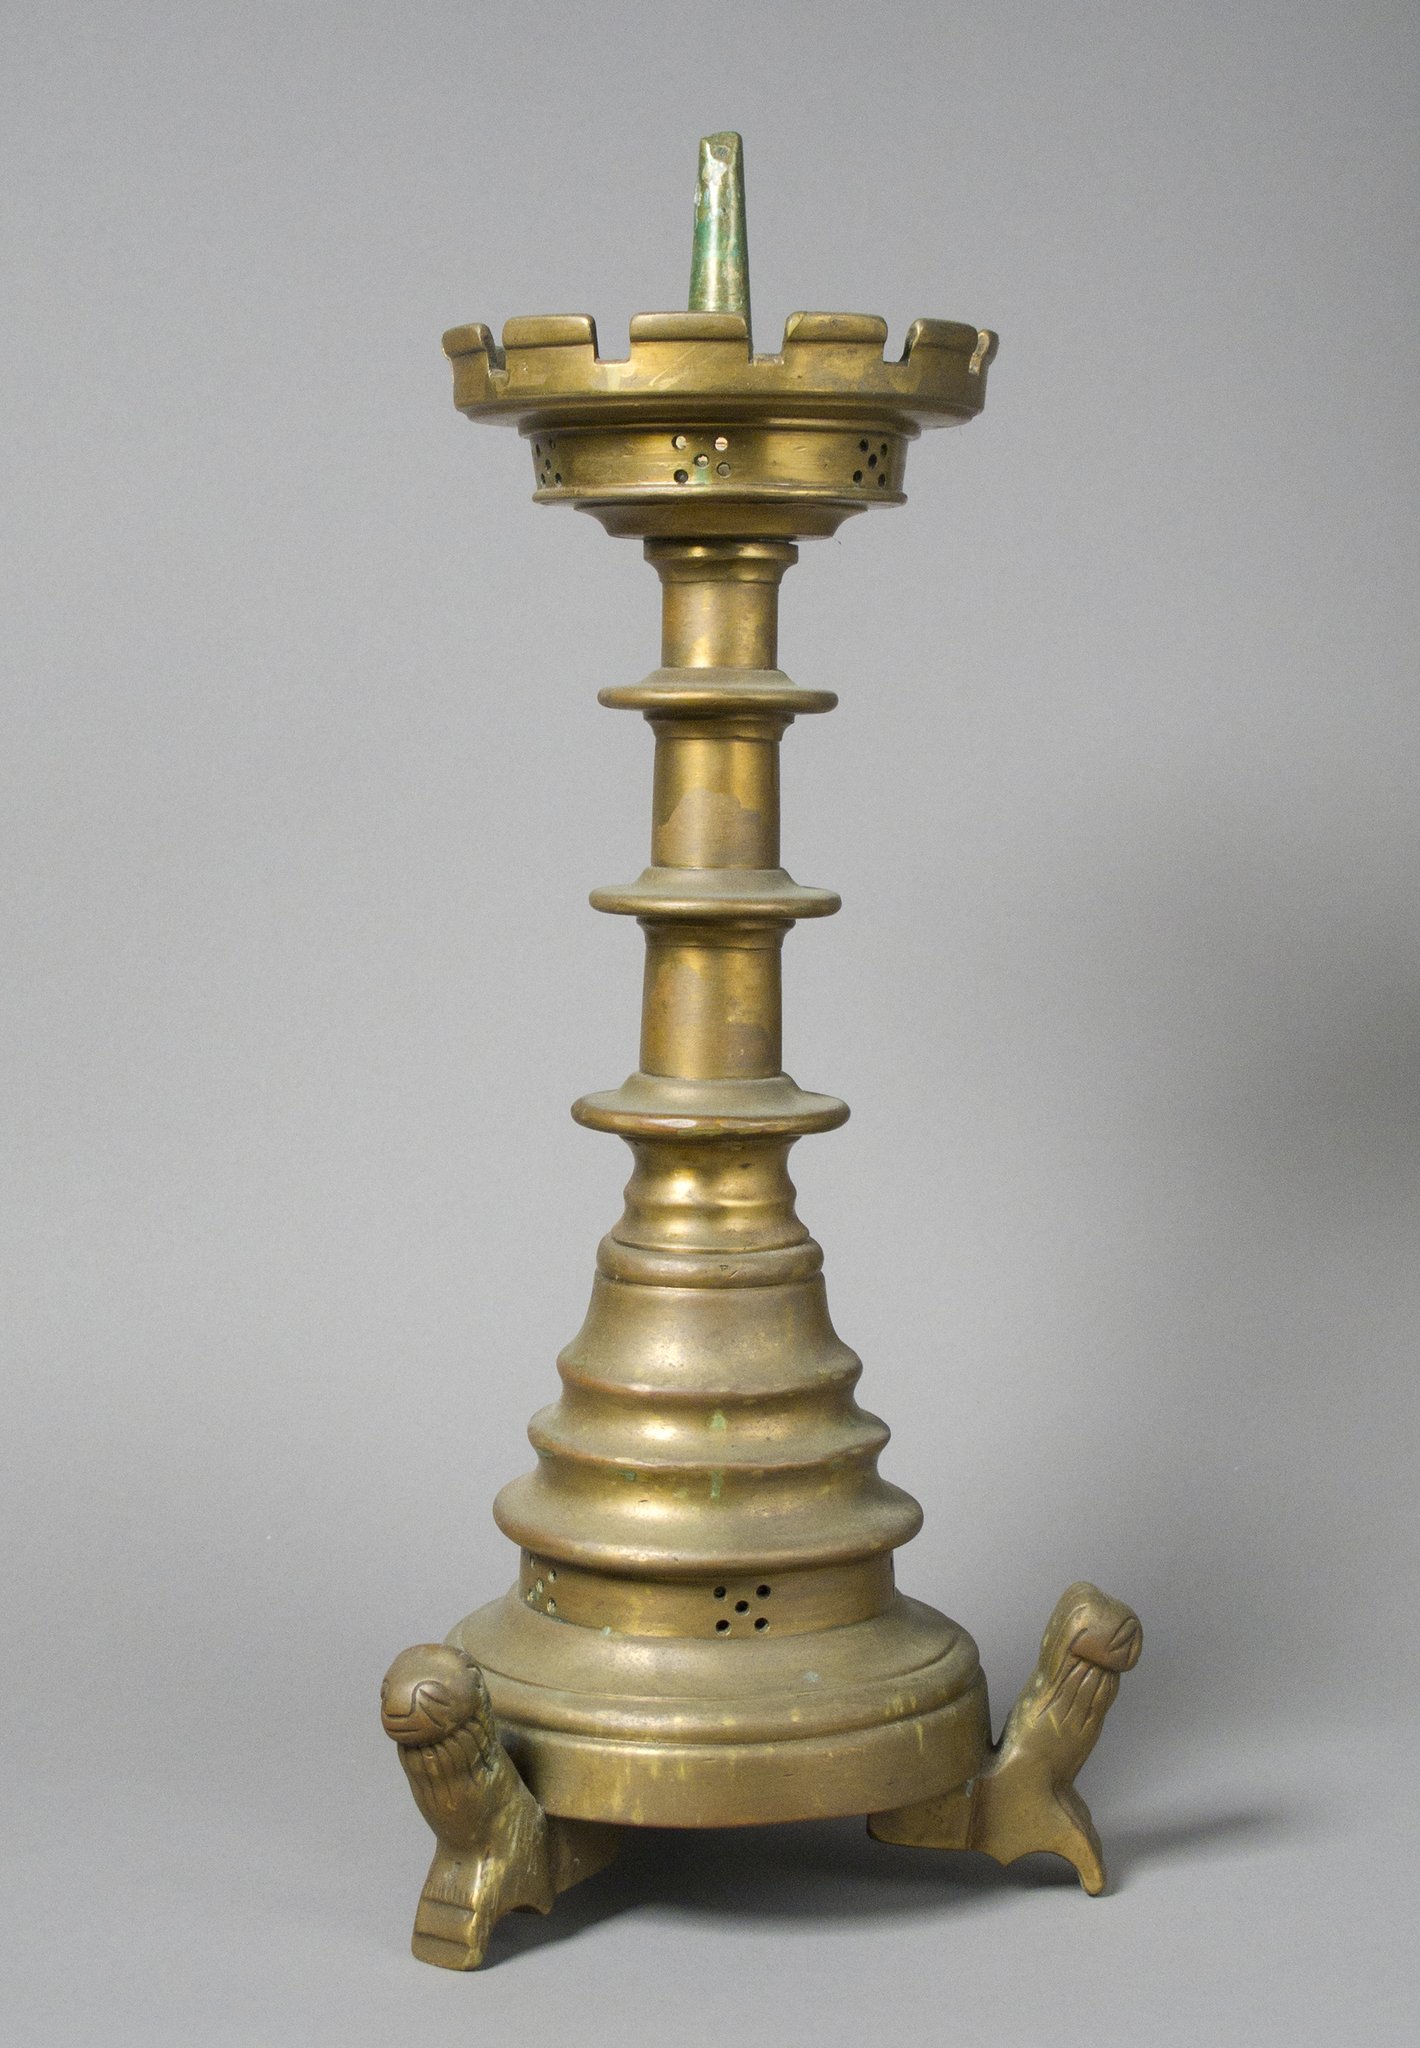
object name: candlestick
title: Candlestick, Pricket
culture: south netherlandish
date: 1401-1500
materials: brass